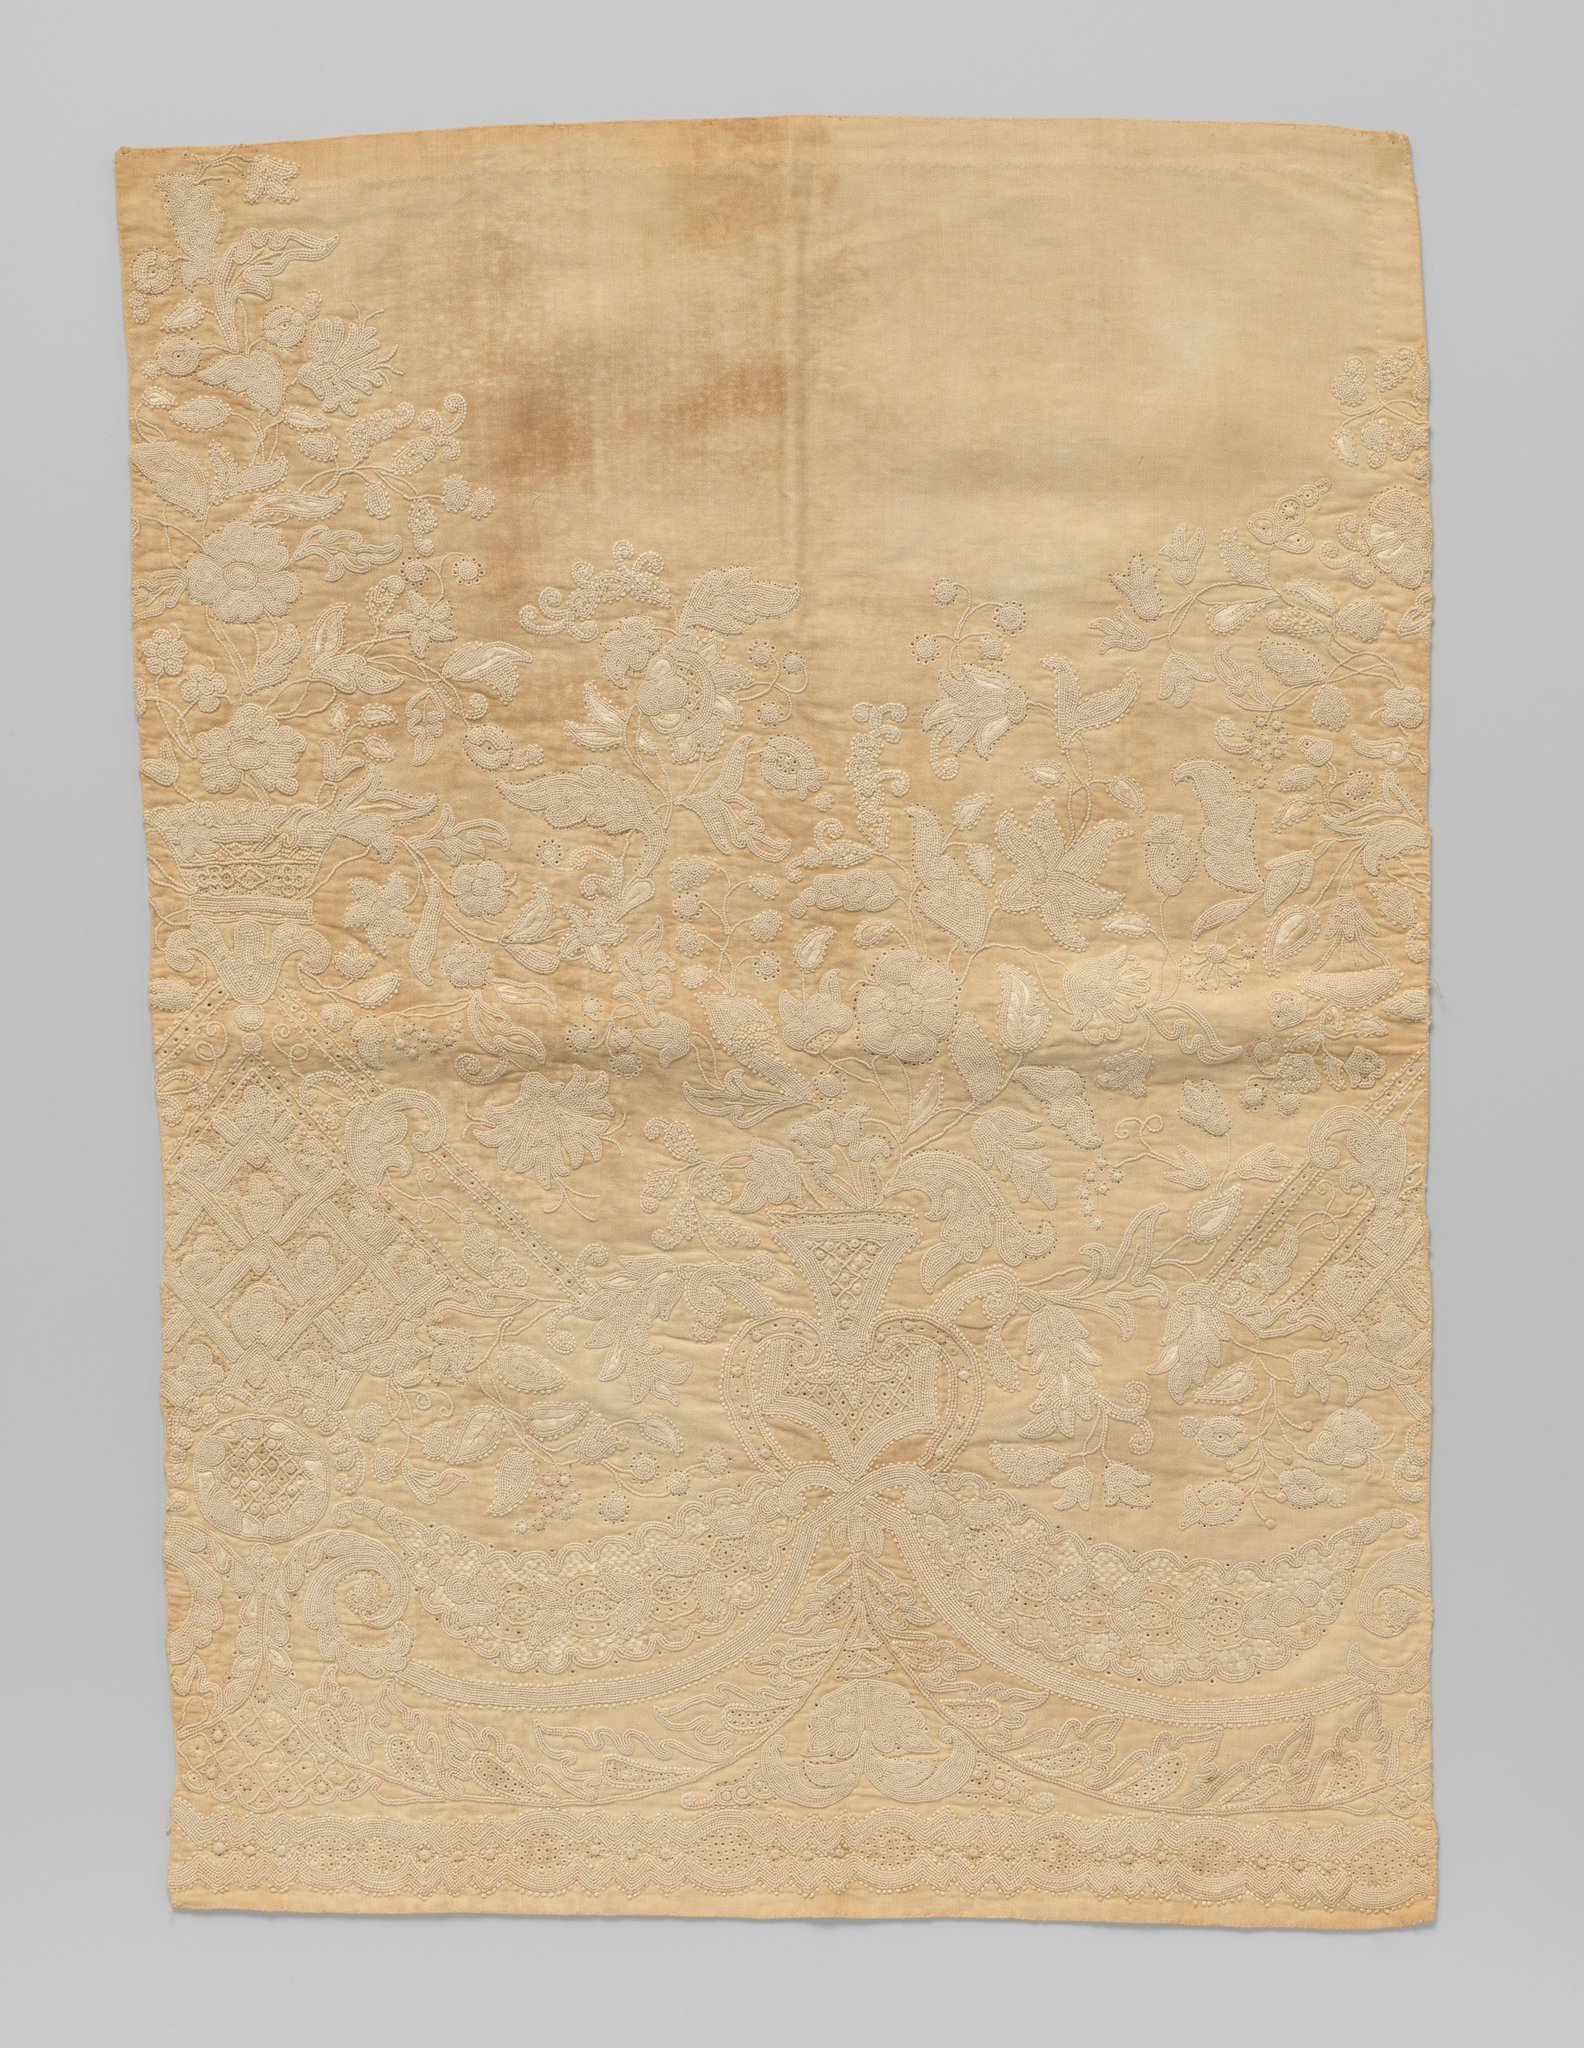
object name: embroidery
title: Borduurwerk in écru op een dito kleurig weefsel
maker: Anonymous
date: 1700-1730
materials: cotton, silk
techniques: embroidered, weave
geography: netherlands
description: Borduurwerk: het écrukleurig weefsel wordt voor een groot deel bedekt door borduurwerk in dezelfde kleur als het weefsel. Het ornament van het borduurwerk is symmetrisch. Langs de onderrand bestaat dit uit een zigzagrand afgewisseld door geschakelde cirkels waarboven golvende bladranken. Daarboven een rand van grote bladranken. Daarboven, links, een ornament opgebouwd uit een ronde vorm, hekwerk in een ruitvorm en een vaas met bloemen en bladeren; aan de linkerzijde incompleet. Rechts daarvan, boven de bladranken, een vaas met bloemen en bladeren. Rechts daarvan, boven de bladranken, herhaalt zich het ornament aan de rechterzijde, eveneens, en meer incompleet.